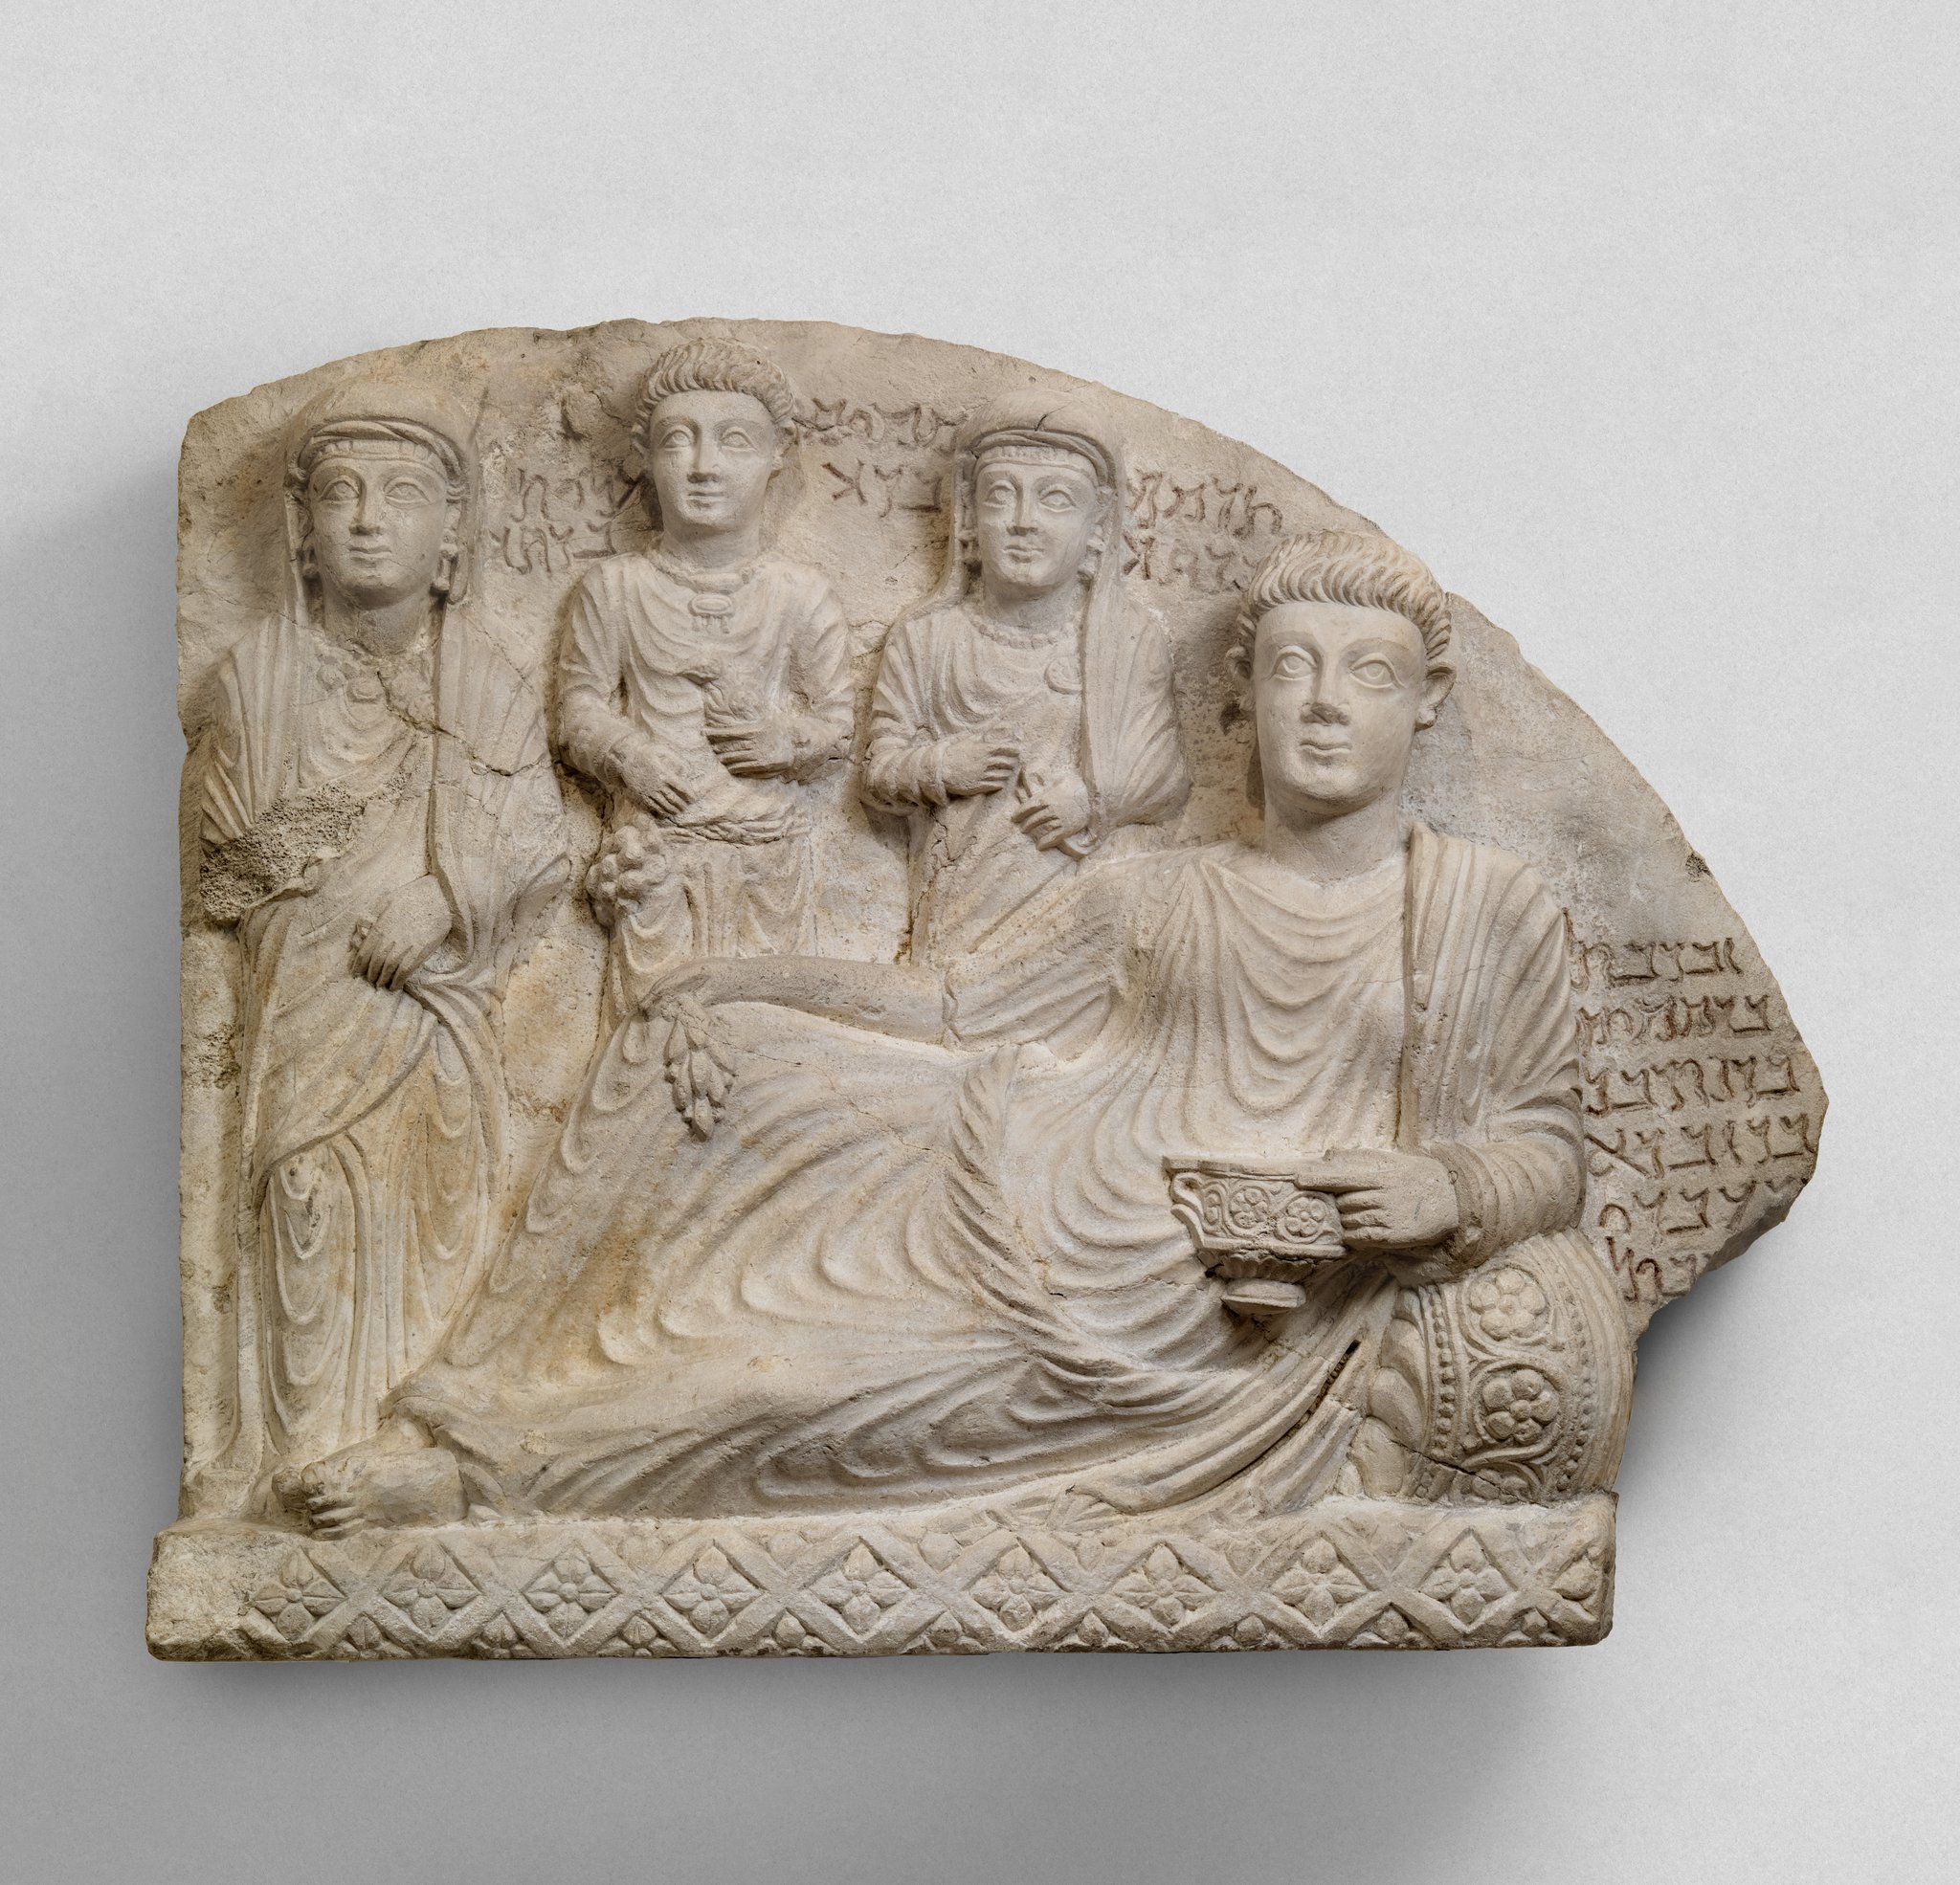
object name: funerary relief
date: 101-300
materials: limestone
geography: syria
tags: men,women,aramaic